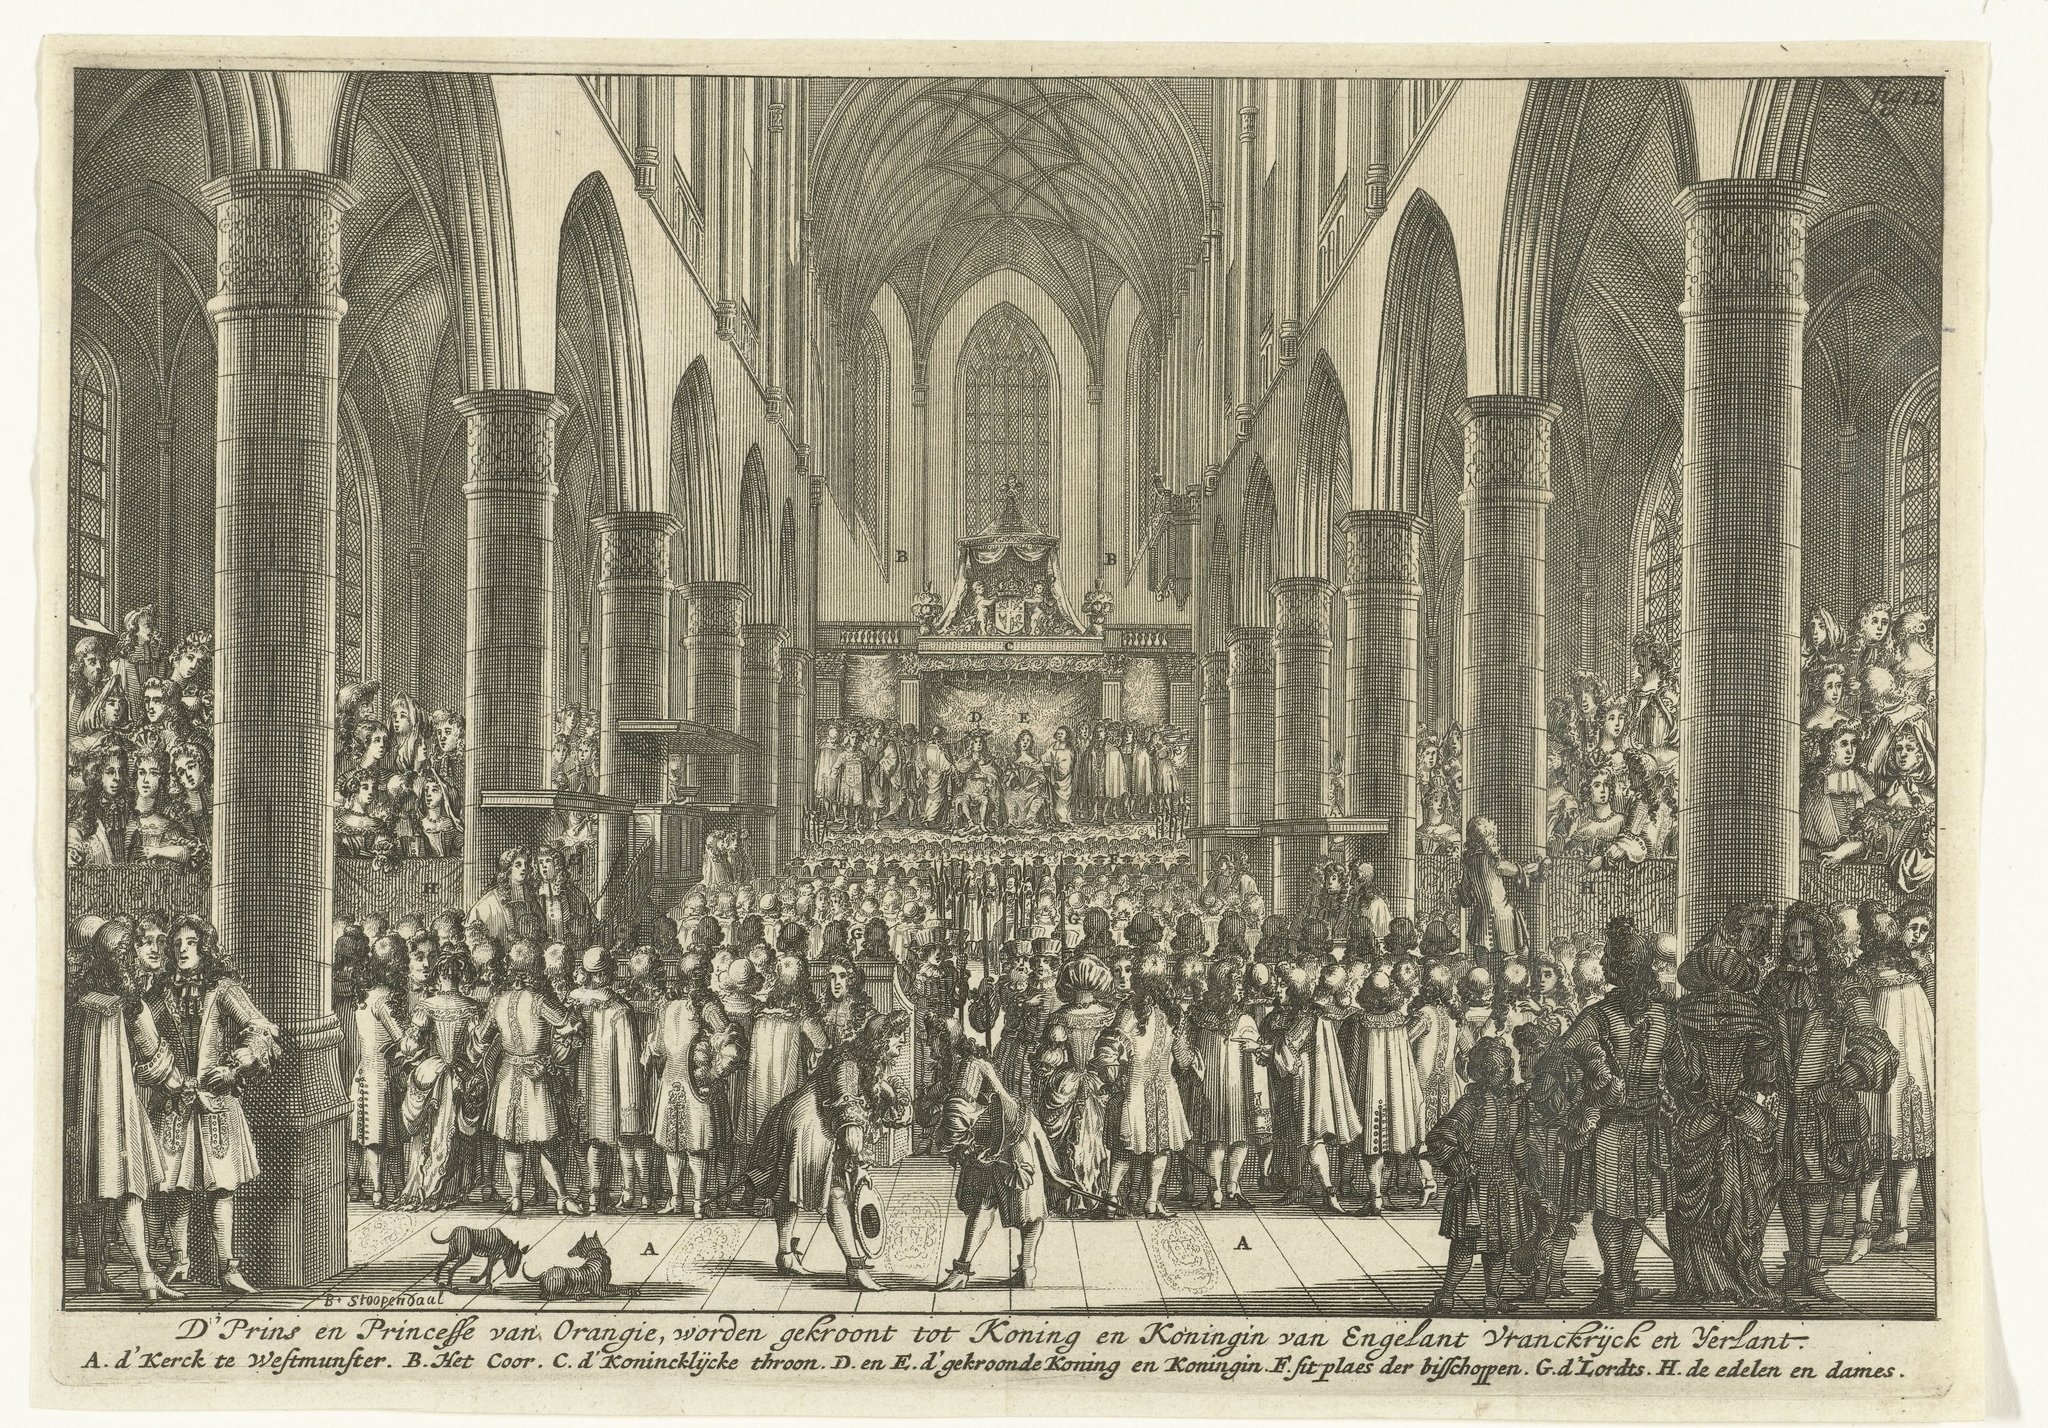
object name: print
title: De kroning van de prins en prinses tot koning en koningin van Engeland, 1689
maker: bastiaen stopendael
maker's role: print maker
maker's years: 1636-1693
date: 1689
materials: paper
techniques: engraving, etching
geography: northern netherlands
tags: the hague, william iii (prince of orange and king of england, scotland, and ireland), london, maria ii stuart (koningin van engeland, schotland en ierland), during the coronation, westminster abbey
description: Gebruikt als illustratie in: Abraham van Poot, Engelands gods-dienst en vryheid hersteld, door syn hoogheid den heere prince van Oranjen, Marcus Willemsz Doornick, Amsterdam, 1689. Niet in Frederik Muller; door het RPK toegevoegd nummer.